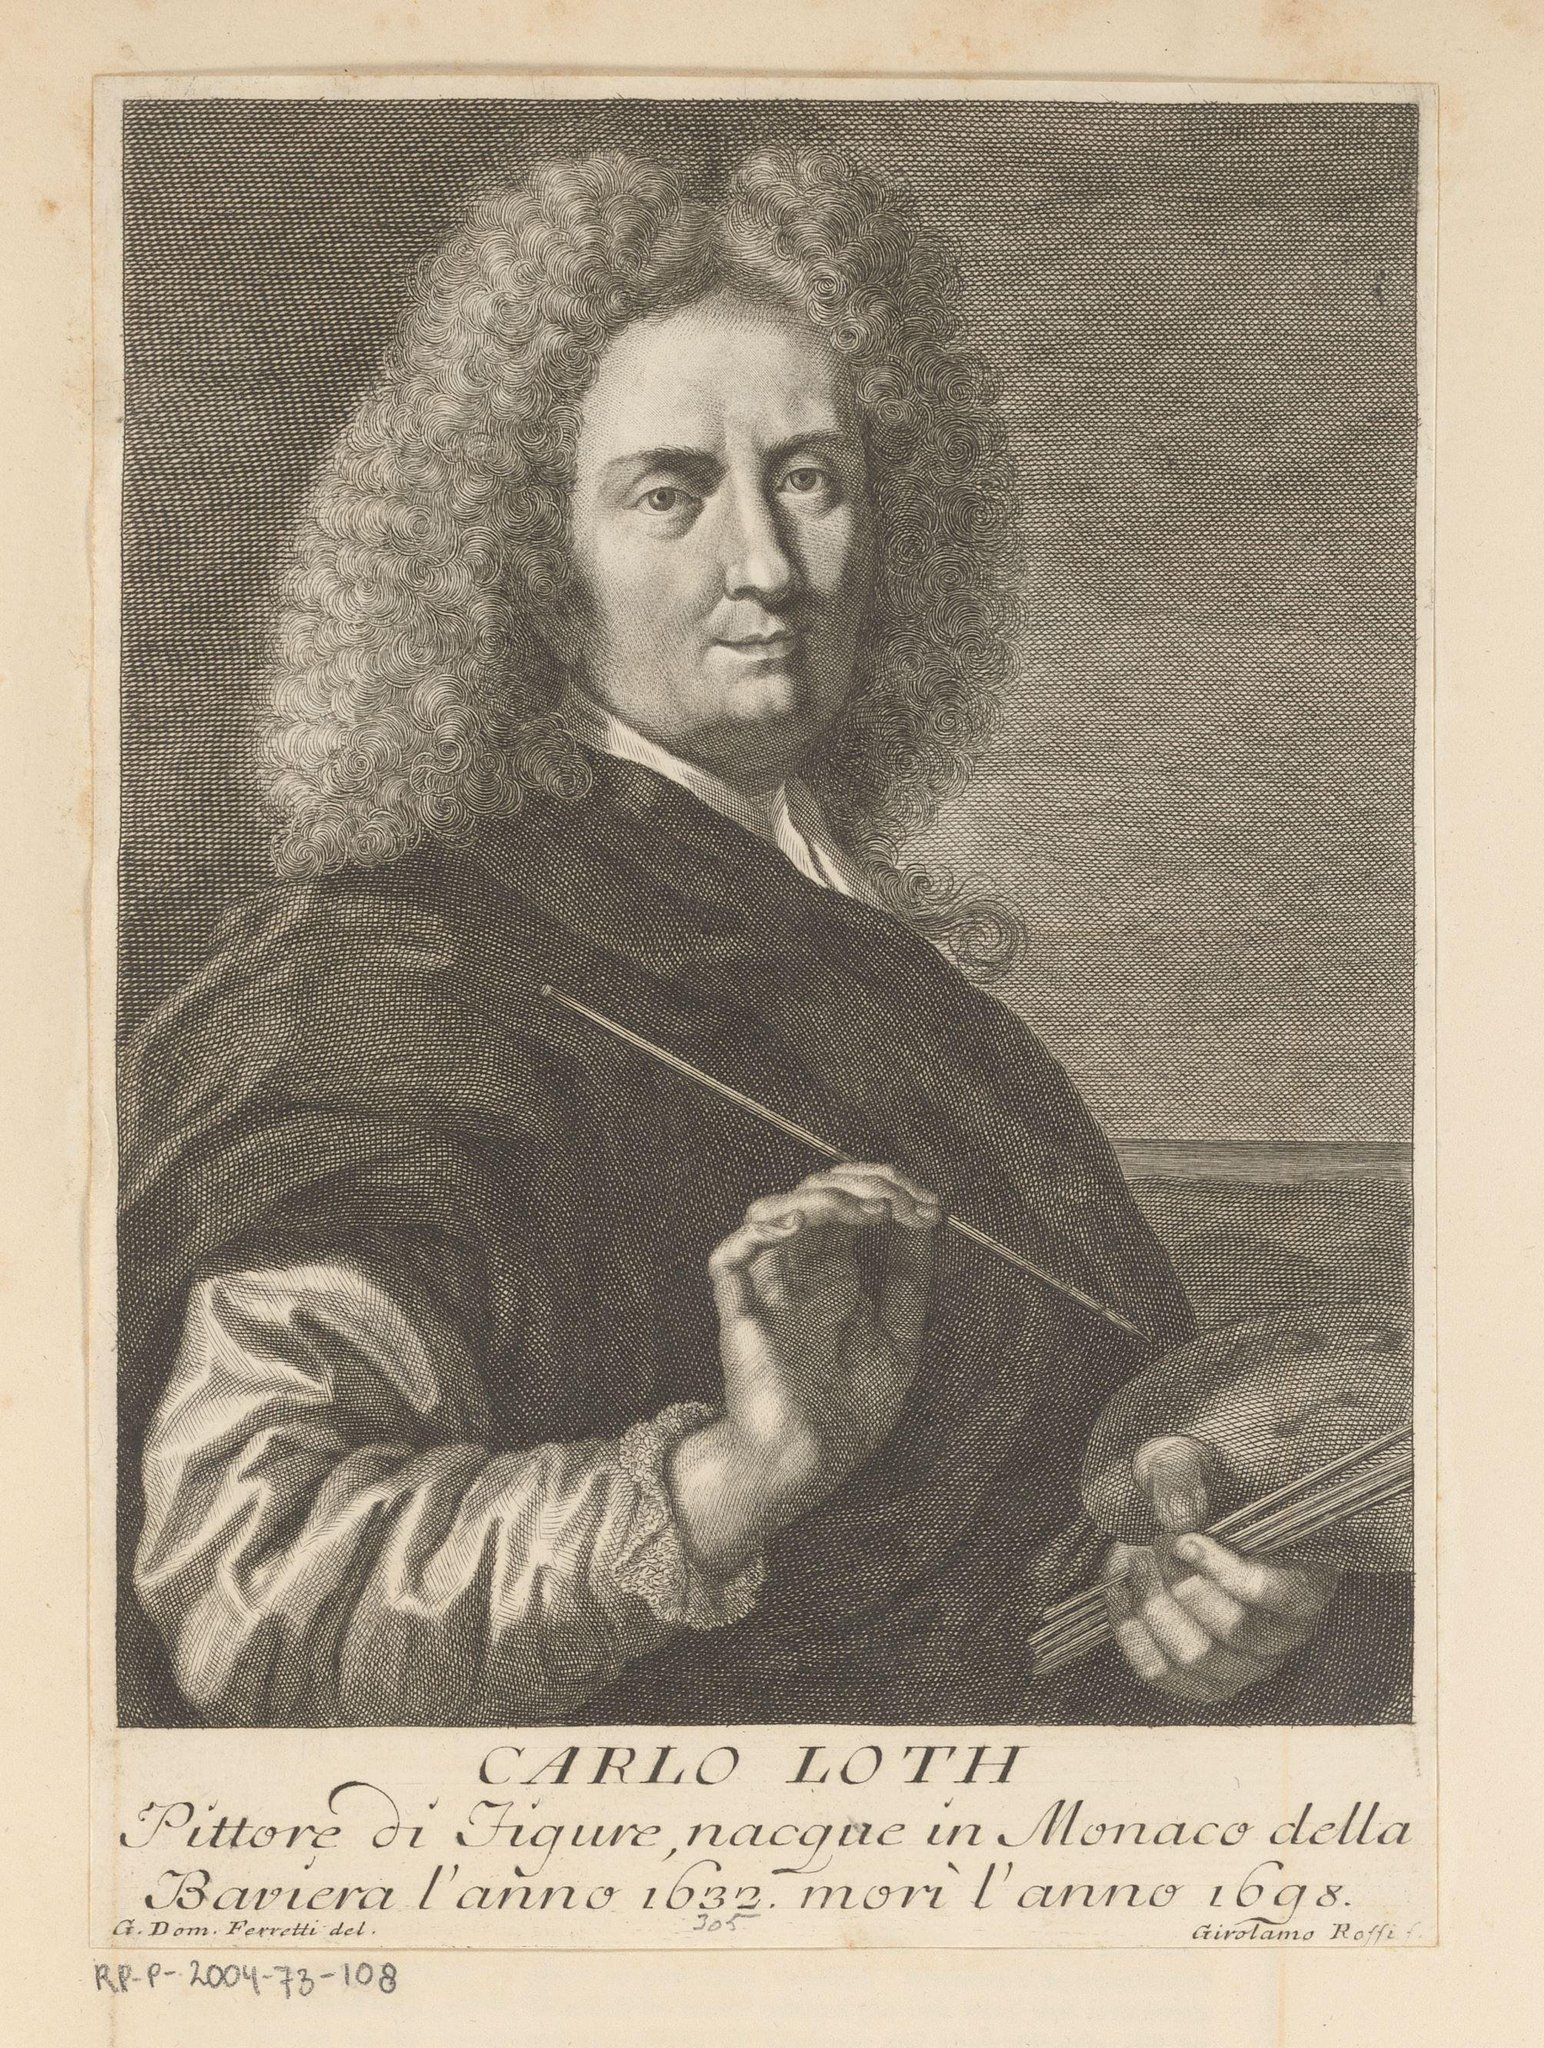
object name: print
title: Museum Florentinum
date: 1752-1766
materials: paper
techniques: engraving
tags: venice, painter, draughtsman, johann carl loth, historical persons, portrait, self-portrait of painter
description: Prent is onderdeel van een serie getiteld 'Museum Florentinum', bestaande uit vier subsecties: 'Gemmae antiquae ex Thesauro Mediceo et privatorum dactyliothecis florentiae...' (1730-1731), 'Statuae antiquae dorum et virorum illustrium' (1734), 'Antiqua numismata aurea et argentea' (1740-1741) en 'Serie di ritratti degli eccellenti pittori' (1752-1766). Het vierde deel bestaat uit 320 kunstenaarsportretten en is uitgegeven in boekvorm (vier delen). Prent uit: Moücke, Francesco. Serie di ritratti degli eccellenti pittori : dipinti di propria mano che esistono nell'Imperial galleria di Firenze. 4 dln. Florence: Francesco Moücke, 1754, dl. 3, p. 251. De samensteller heeft deze prent in het album geplakt als illustratie bij: Pilkington, Matthew en Johann Heinrich Füssli. A dictionary of painters, from the revival of the art to the present period. 4 dln. Londen: John Crowder, 1805, dl. 2, p. 297.